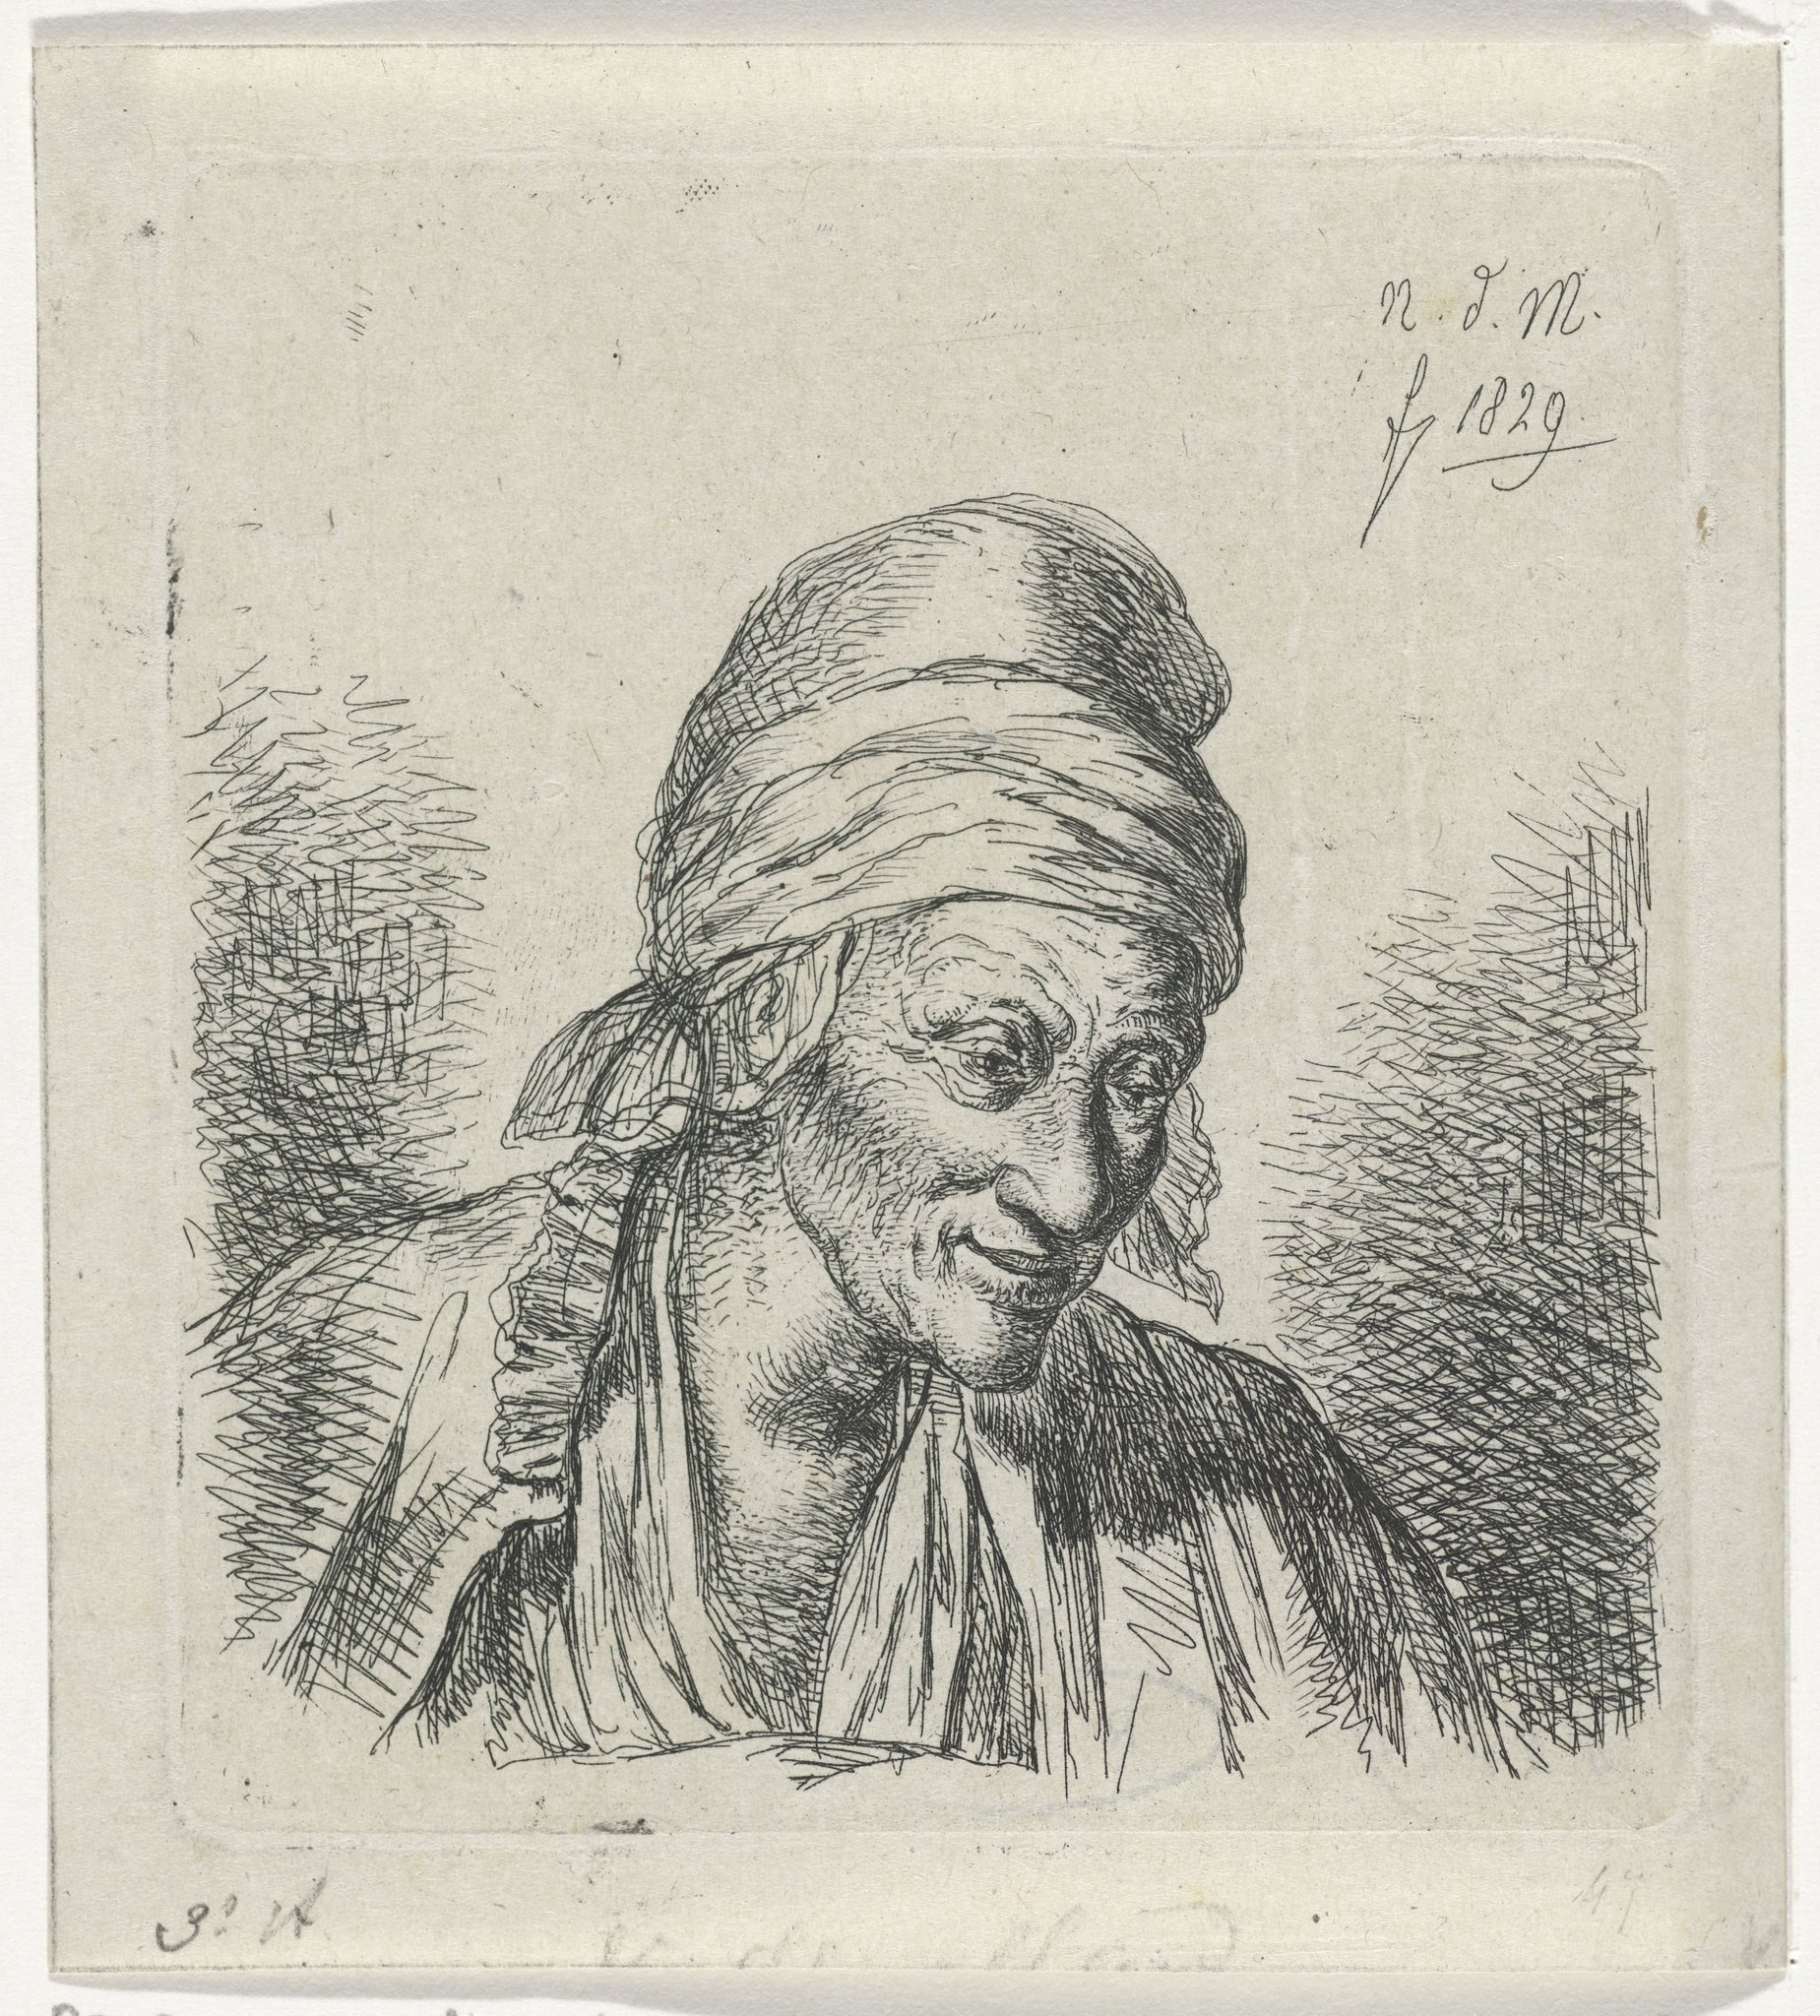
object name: print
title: Oude vrouw naar rechts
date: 1829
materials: paper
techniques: etching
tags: old woman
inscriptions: collector's mark: Lugt 2228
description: Buste van een glimlachende oude vrouw naar rechts.